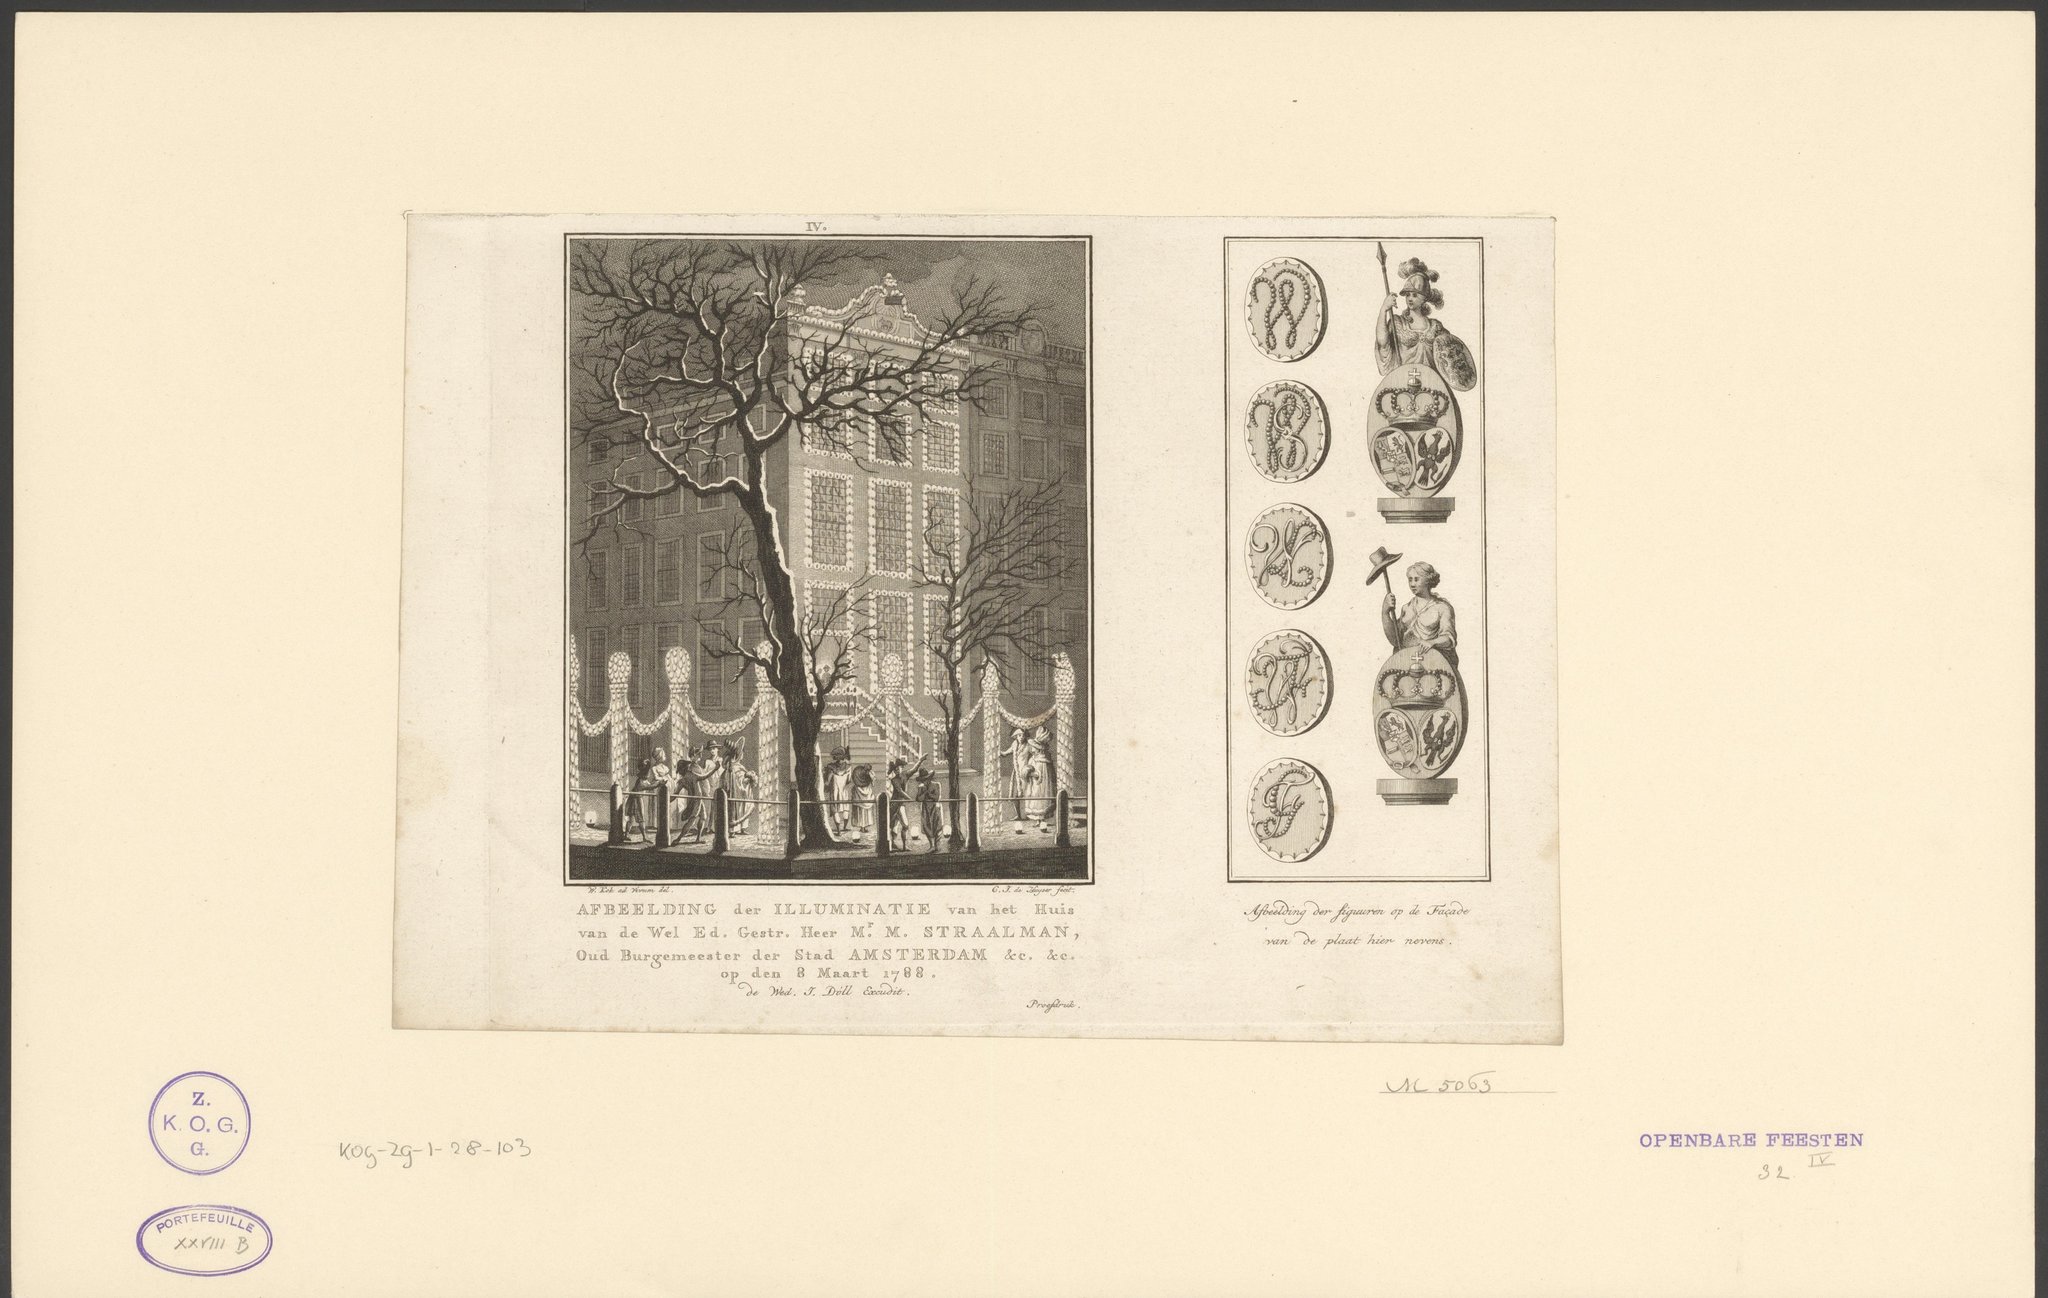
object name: print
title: Afbeelding der Illuminatie van het Huis van de Wel Ed. Gestr. Heer Mr. M. Straalman, Oud Burgemeester der Stad Amsterdam, op den 8sten Maart 1788 / Afbeelding der figuuren op de Façade van de plaat hier nevens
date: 1788-1790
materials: paper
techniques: engraving, etching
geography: amsterdam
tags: the hague, william v (prince of orange), amsterdam, mayor, matthys straalman, bonfire, fire-works (+ festive decoration ~ festive activities), freedom, liberty; 'libertà' (ripa), armorial bearing, heraldry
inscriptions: collector's mark: Lugt 1641, stamp, stamp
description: Illuminatie aangebracht op de gevel van en voor het huis van mr. Matthys Straalman, oud-burgemeester te Amsterdam. Met details van de figuren in de decoraties. Genummerd bovenaan: IV. Onderdeel van een reeks van twaalf platen van de illuminaties en decoraties te Amsterdam op de 40ste verjaardag van prins Willem V op 8 maart 1788. Onderwerpsrubrieken binnen de Atlas Zeden en Gewoonten: Zeden en Gewoonten in Engeren Zin. Volksleven. Openbare feesten. Vorstelijke intochten, (Illuminaties, vuurwerken en dergelijke, openbare feesten).